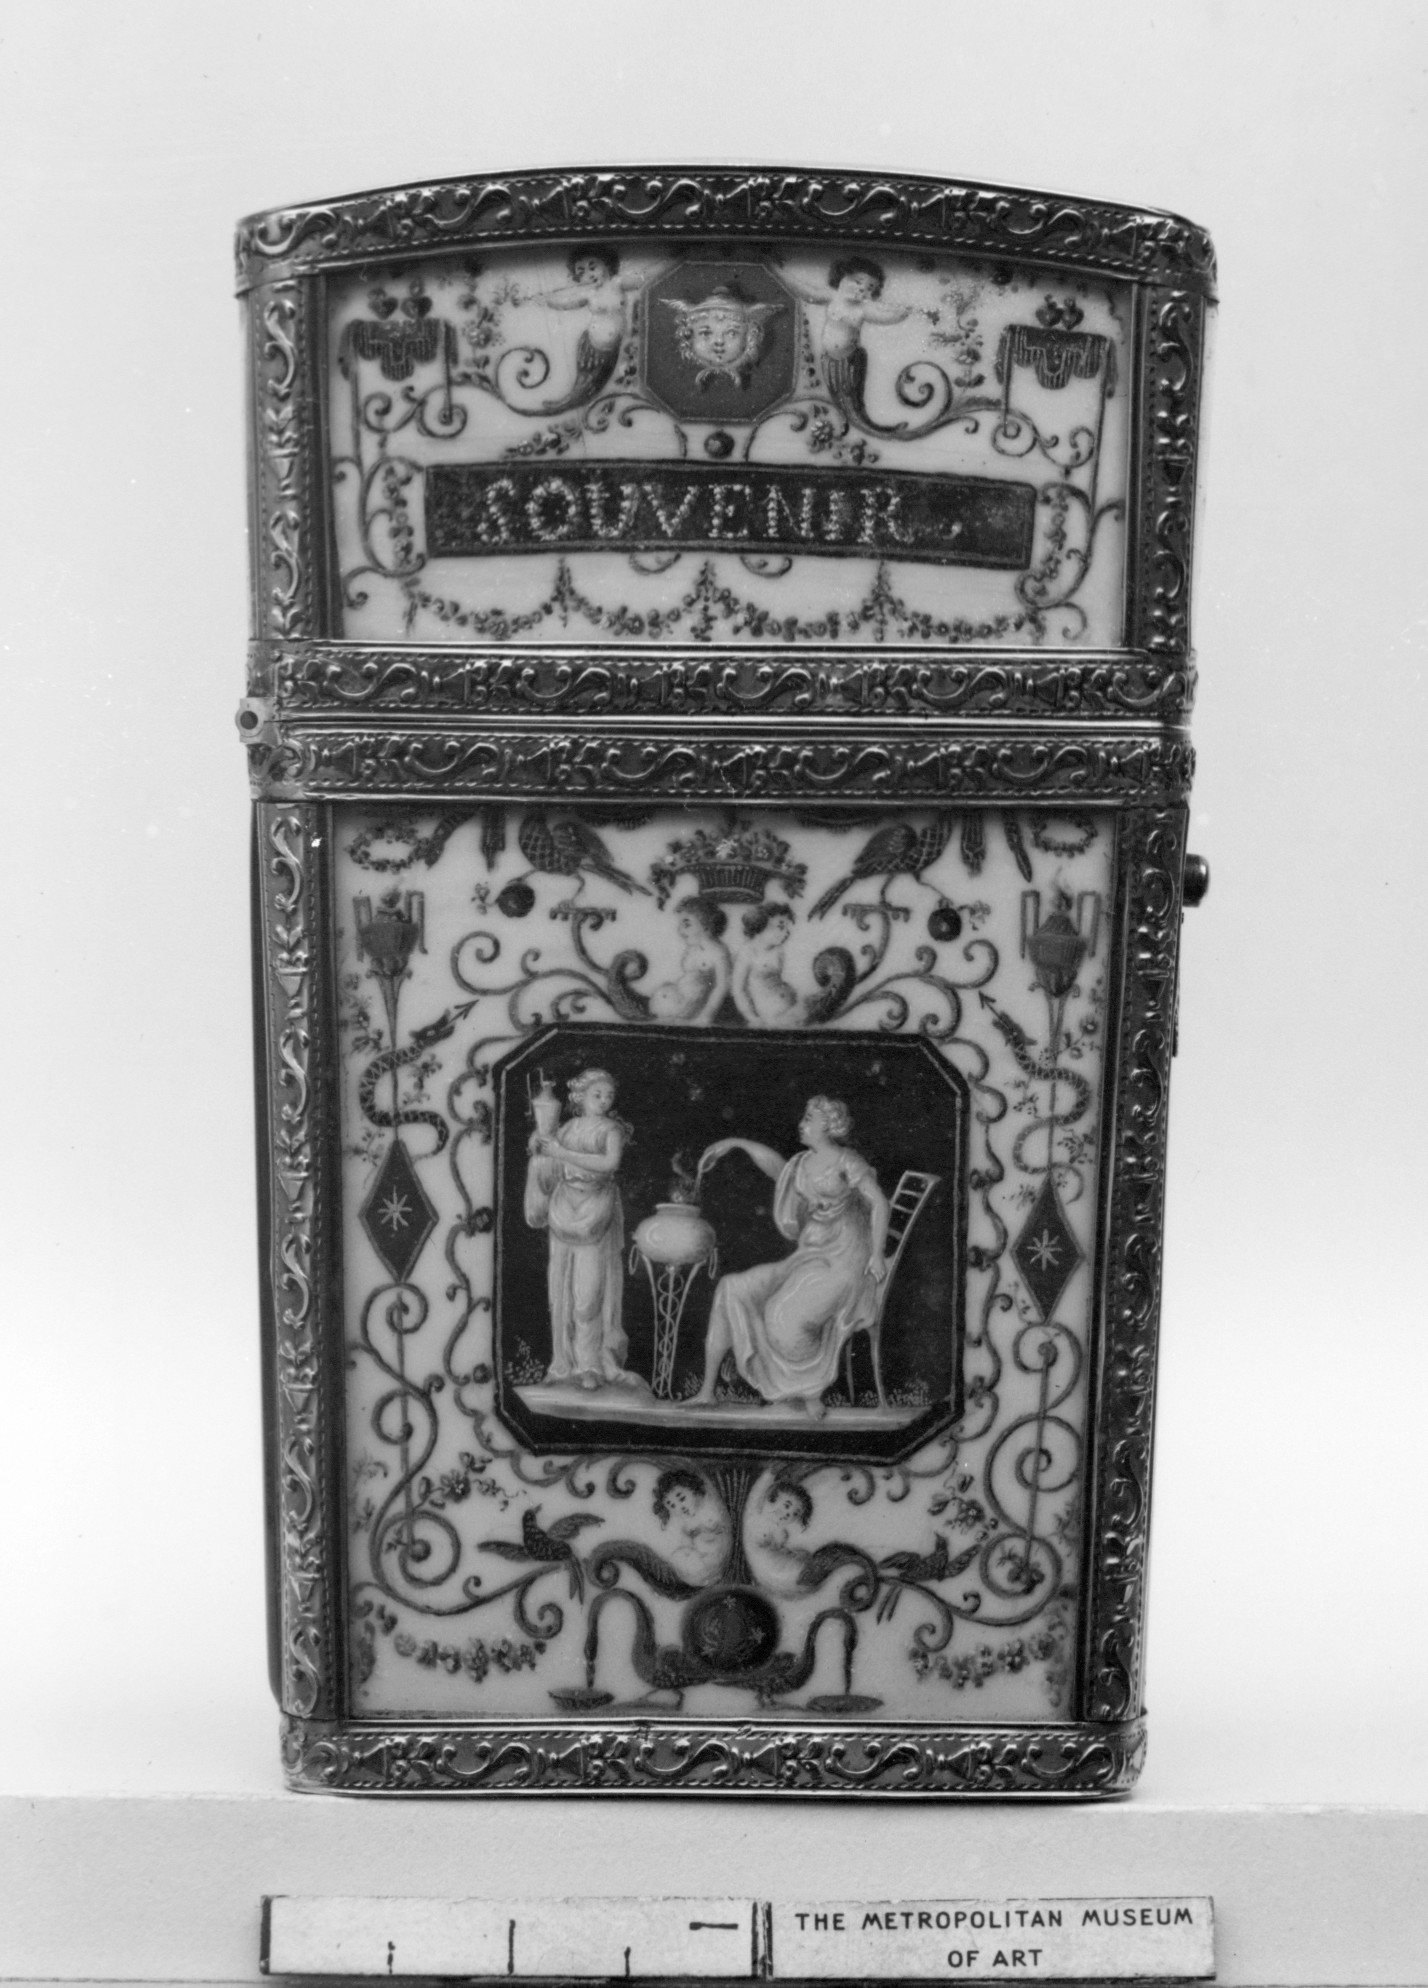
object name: souvenir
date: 1786-1787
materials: gold, ivory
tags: birds,women,dragons